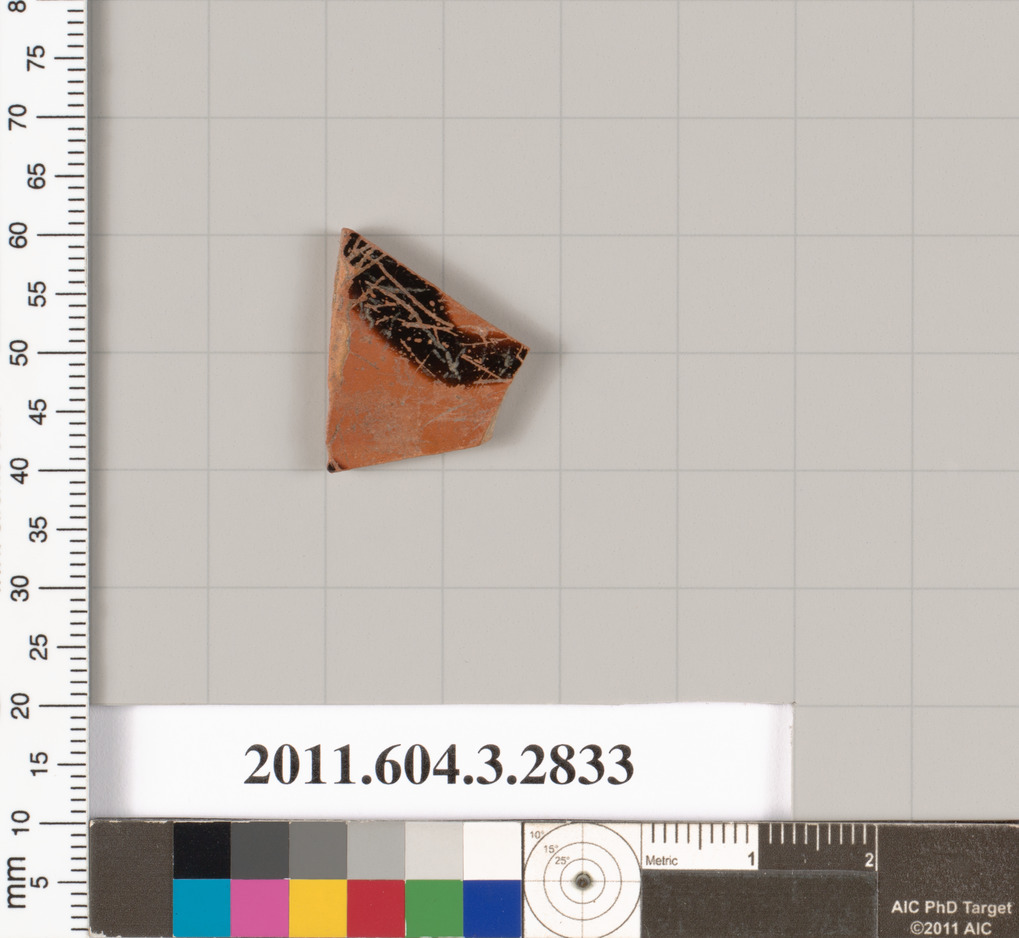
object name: undetermined closed shape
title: Terracotta fragment of a closed shape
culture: greek, attic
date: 510-500 BCE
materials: terracotta